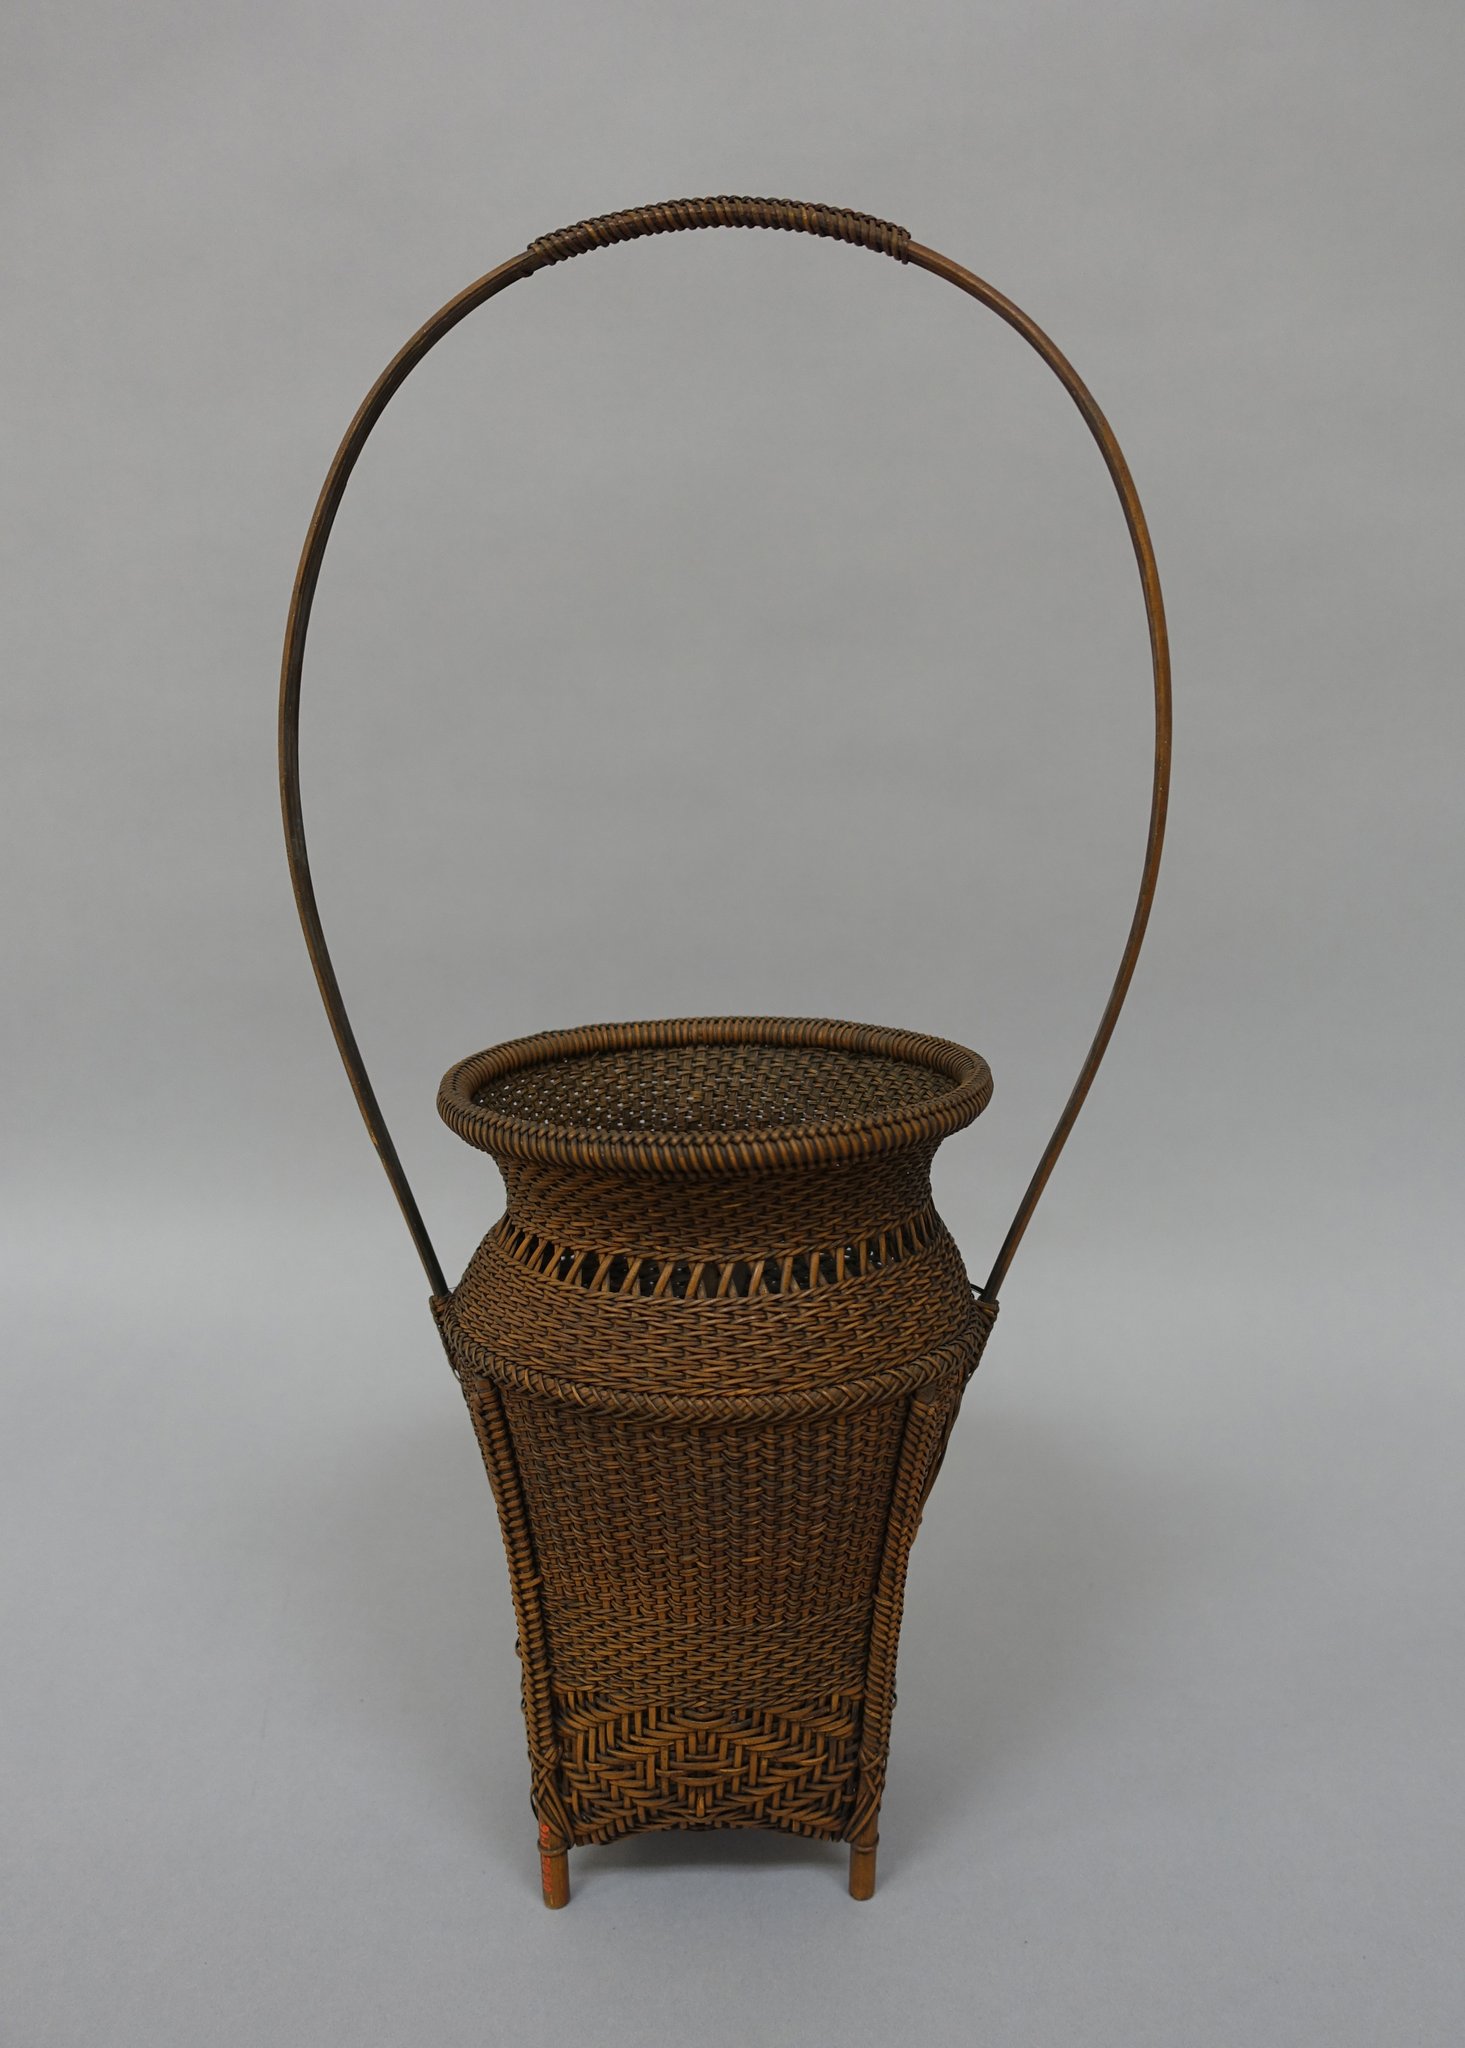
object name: basket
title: Karamono-Style Basket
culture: japanese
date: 1801-1900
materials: bamboo